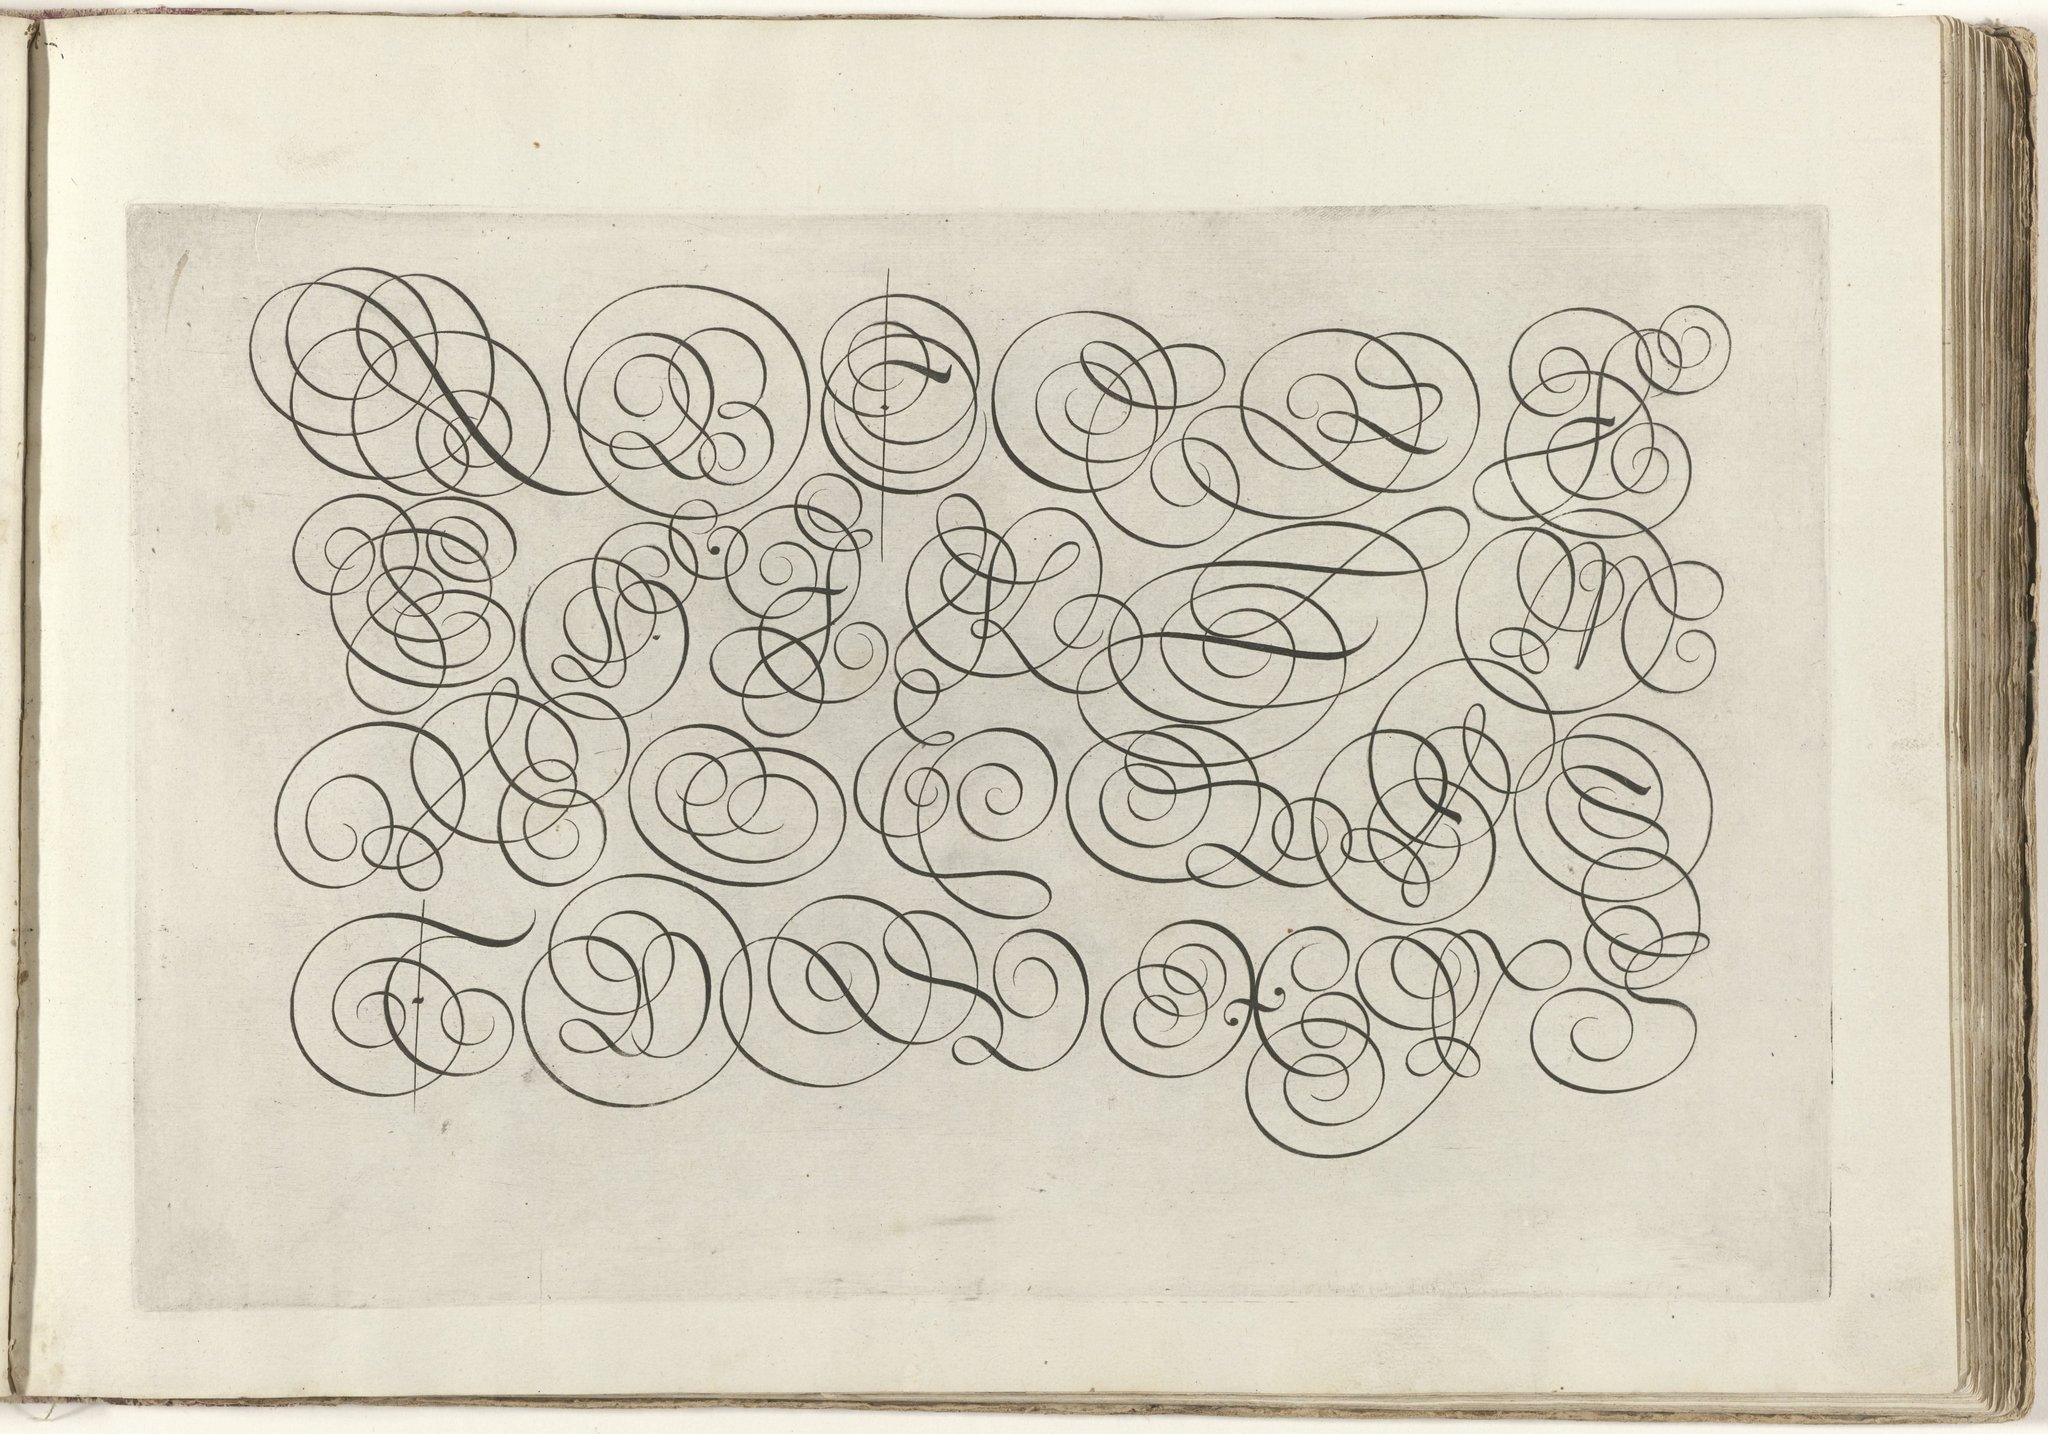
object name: album leaf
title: Schrijfvoorbeeld: het alfabet in vier regels kapitalen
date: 1605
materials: paper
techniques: engraving, intaglio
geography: amsterdam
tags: calligraphy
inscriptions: collector's mark: Lugt 2228, collector's mark: Lugt 2760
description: Schrijfvoorbeeld met het alfabet in vier regels kapitalen. De prent maakt deel uit van een album.